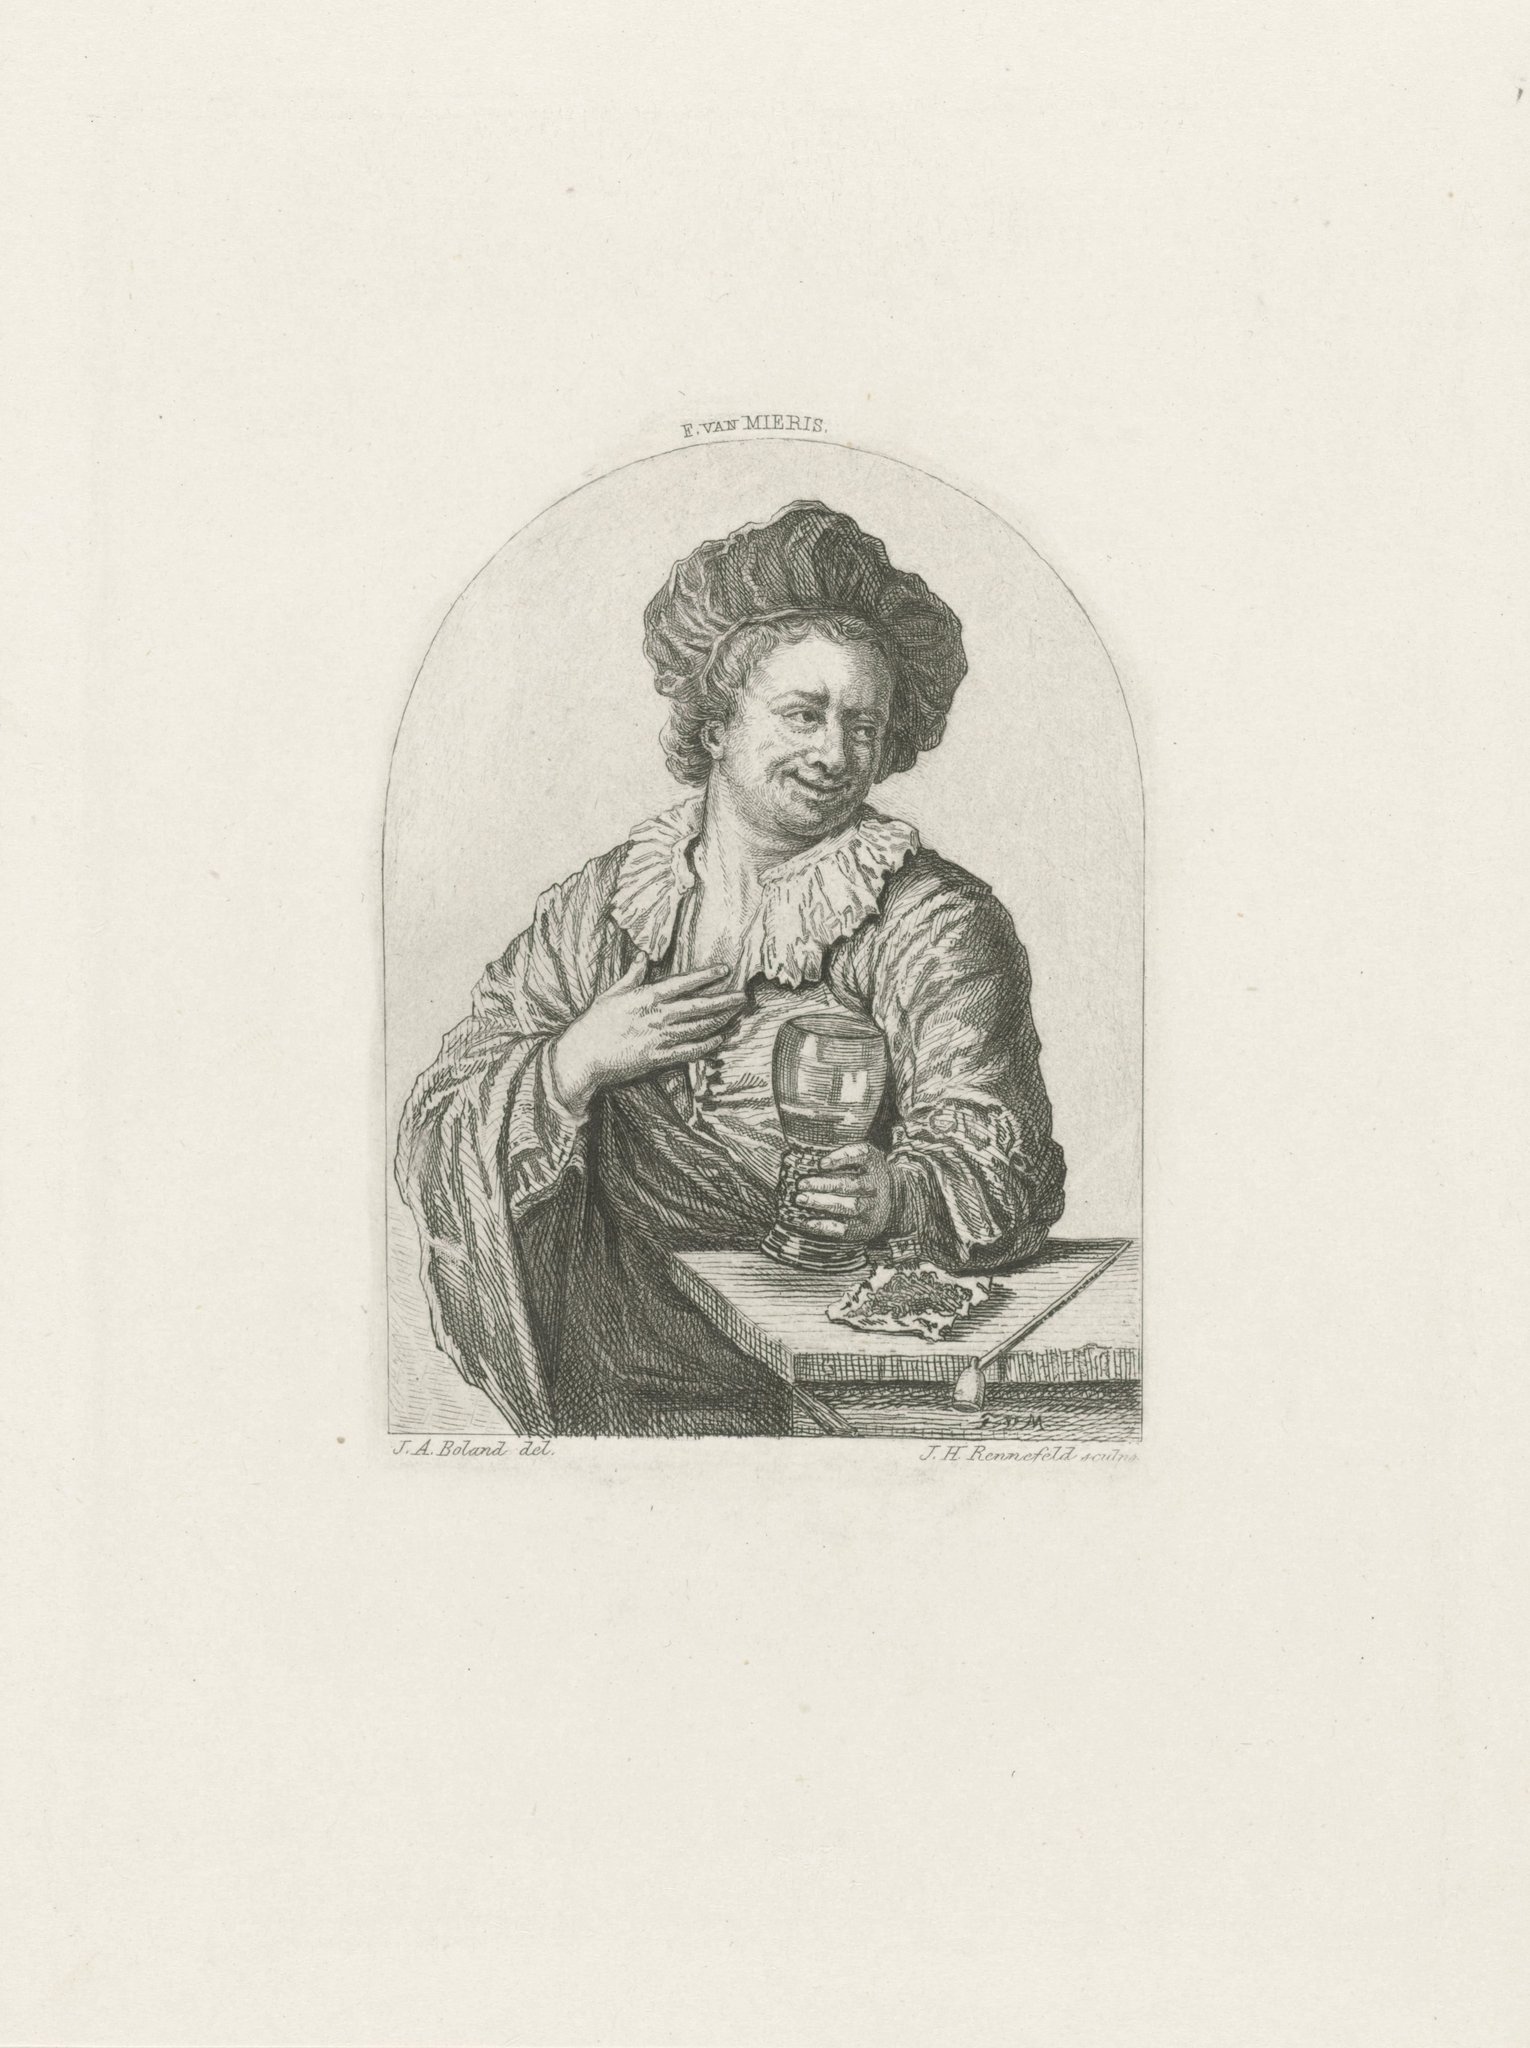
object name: print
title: Man met roemer en tabak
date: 1842-1877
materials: paper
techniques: etching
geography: amsterdam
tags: pipe ~ tobacco, glass, rummer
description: Een man met een roemer in de hand leunt met zijn arm op een tafel waar een pijp en tabak op liggen.